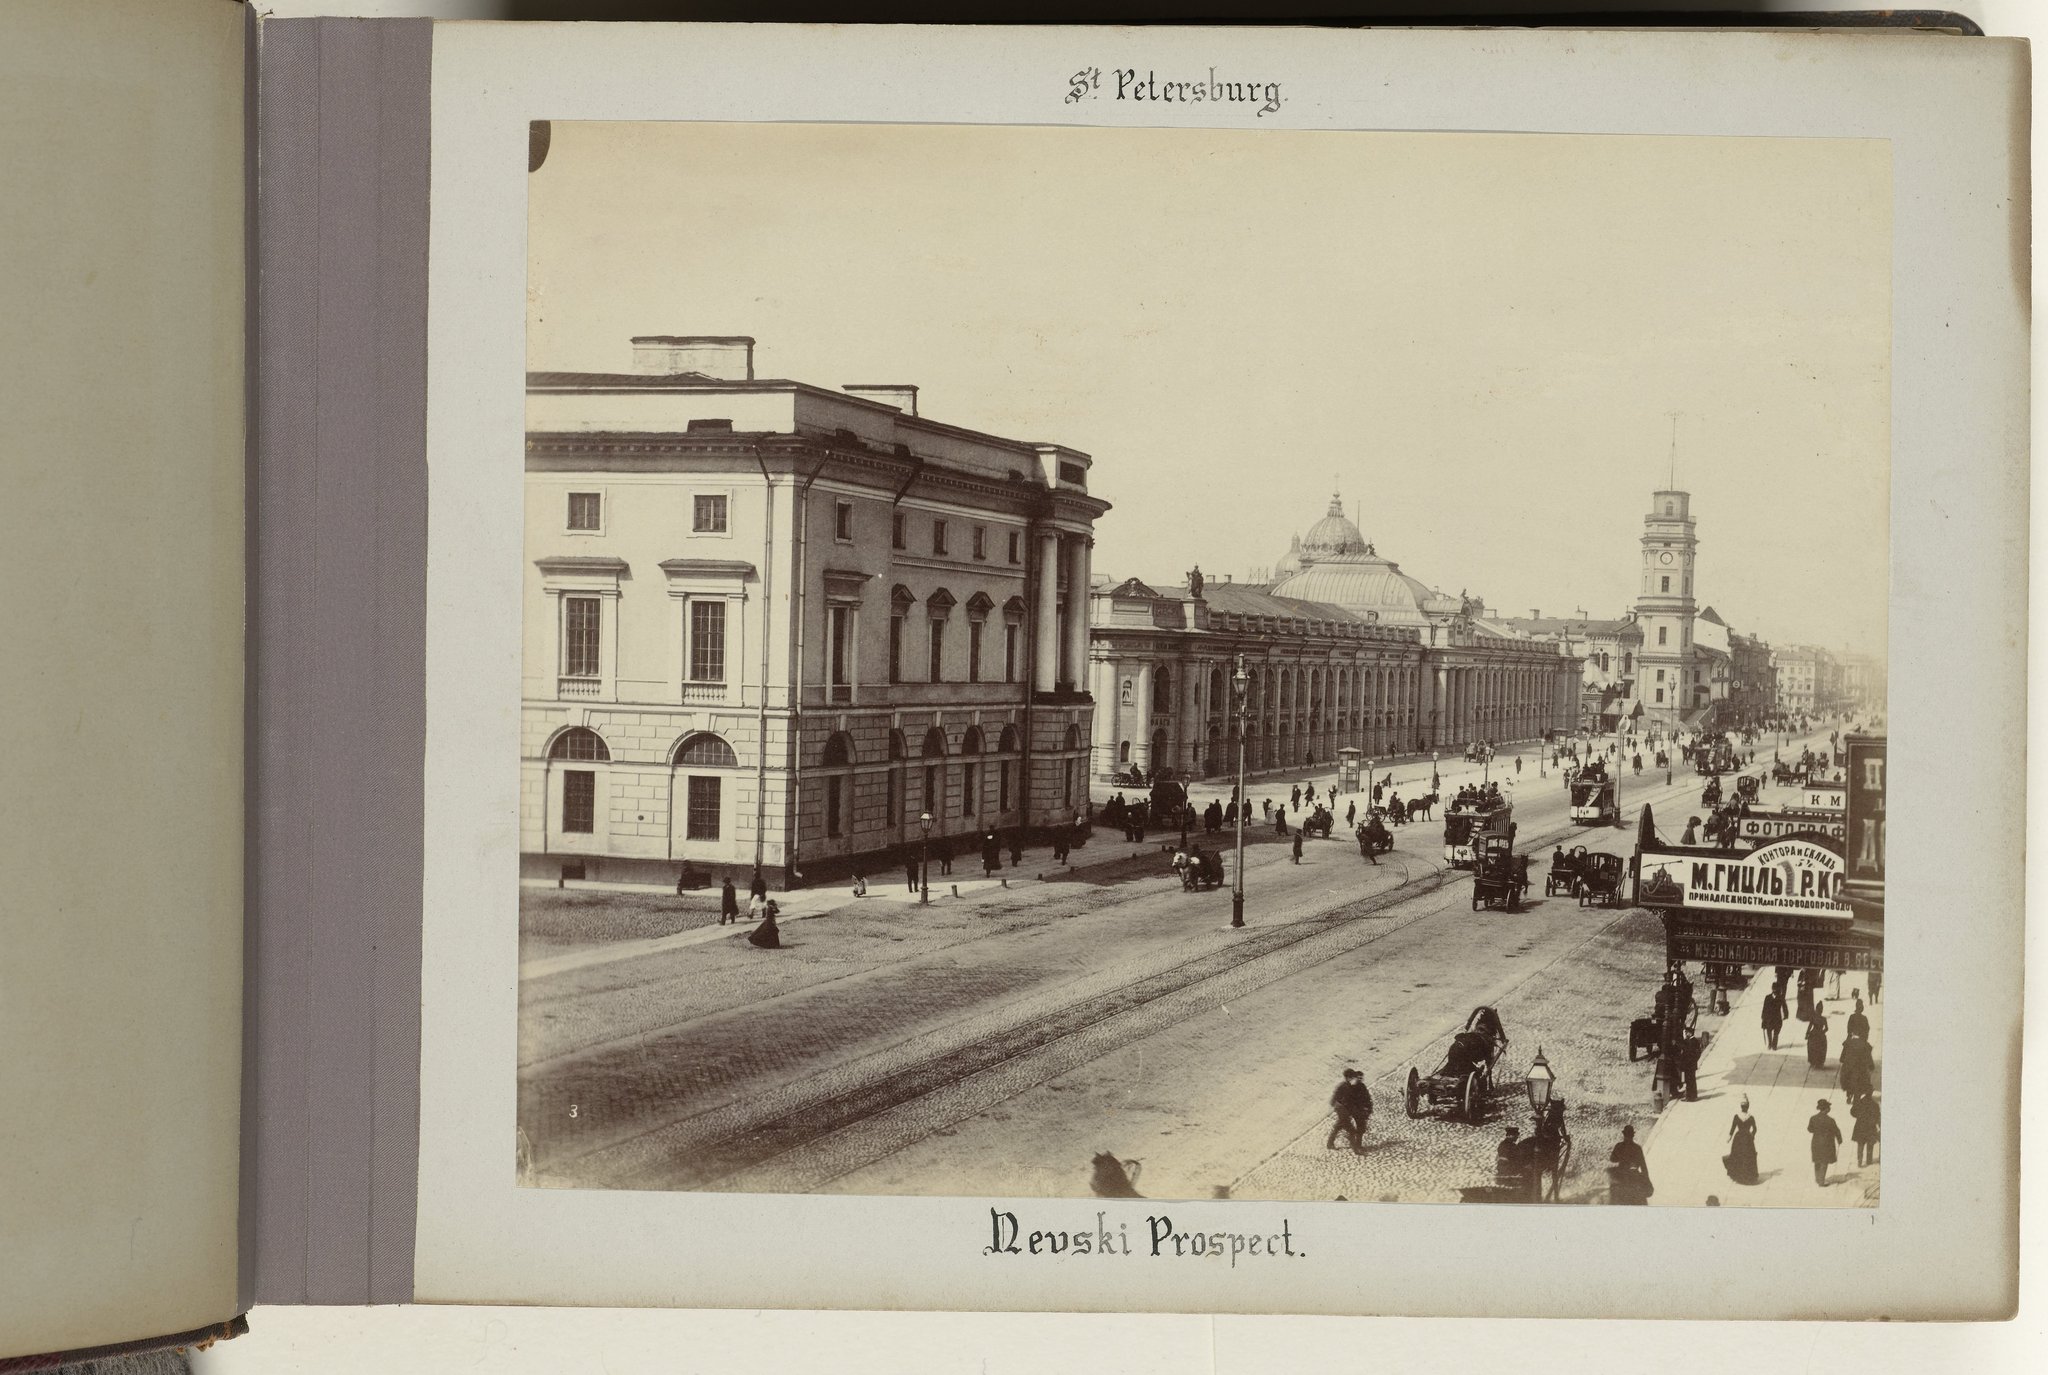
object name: photograph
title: Nevski Prospekt, de hoofdstraat in Sint Petersburg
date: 1898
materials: cardboard, paper, photographic support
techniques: albumen print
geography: sint-petersburg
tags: sint-petersburg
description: Nevski Prospekt, de brede avenue van Sint Petersburg. Op straat verkeer van bussen en rijtuigen voortgetrokken door paarden. Aan de linkerzijde is het 18de-eeuwse warenhuis Gostiny Dvor afgebeeld. Rechts op de gevel het uithangbord van fotograaf Karl Bulla die op nr. 54 zijn atelier had.